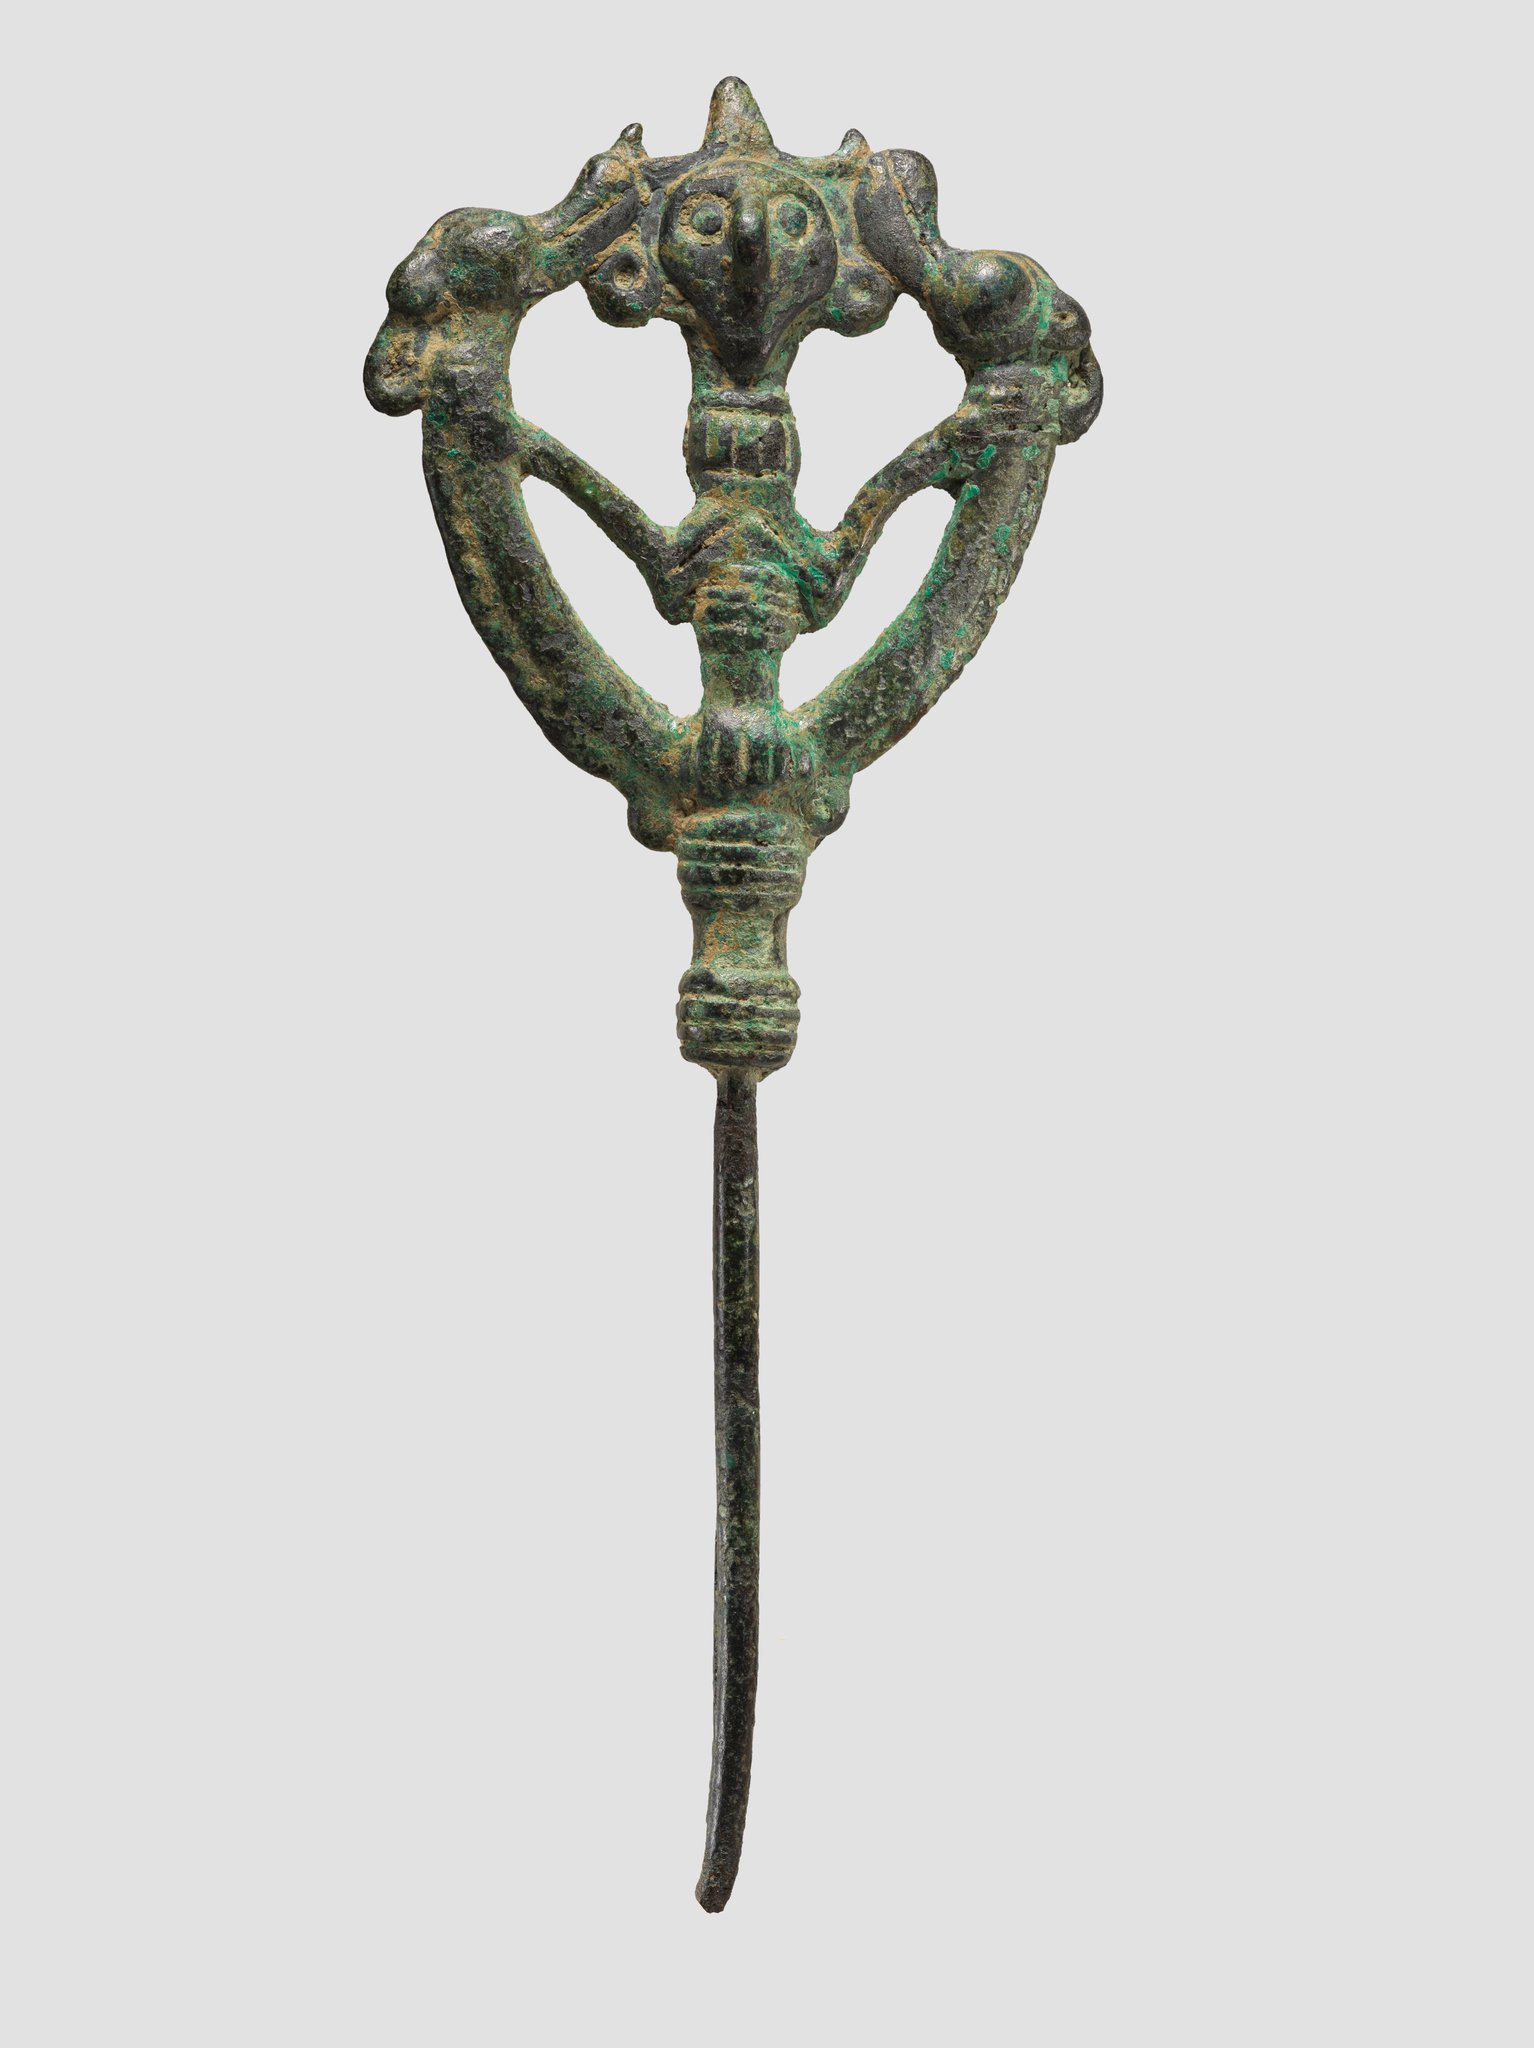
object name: pin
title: Openwork pin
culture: iranian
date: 800-601 BCE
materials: bronze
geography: iran, probably from luristan